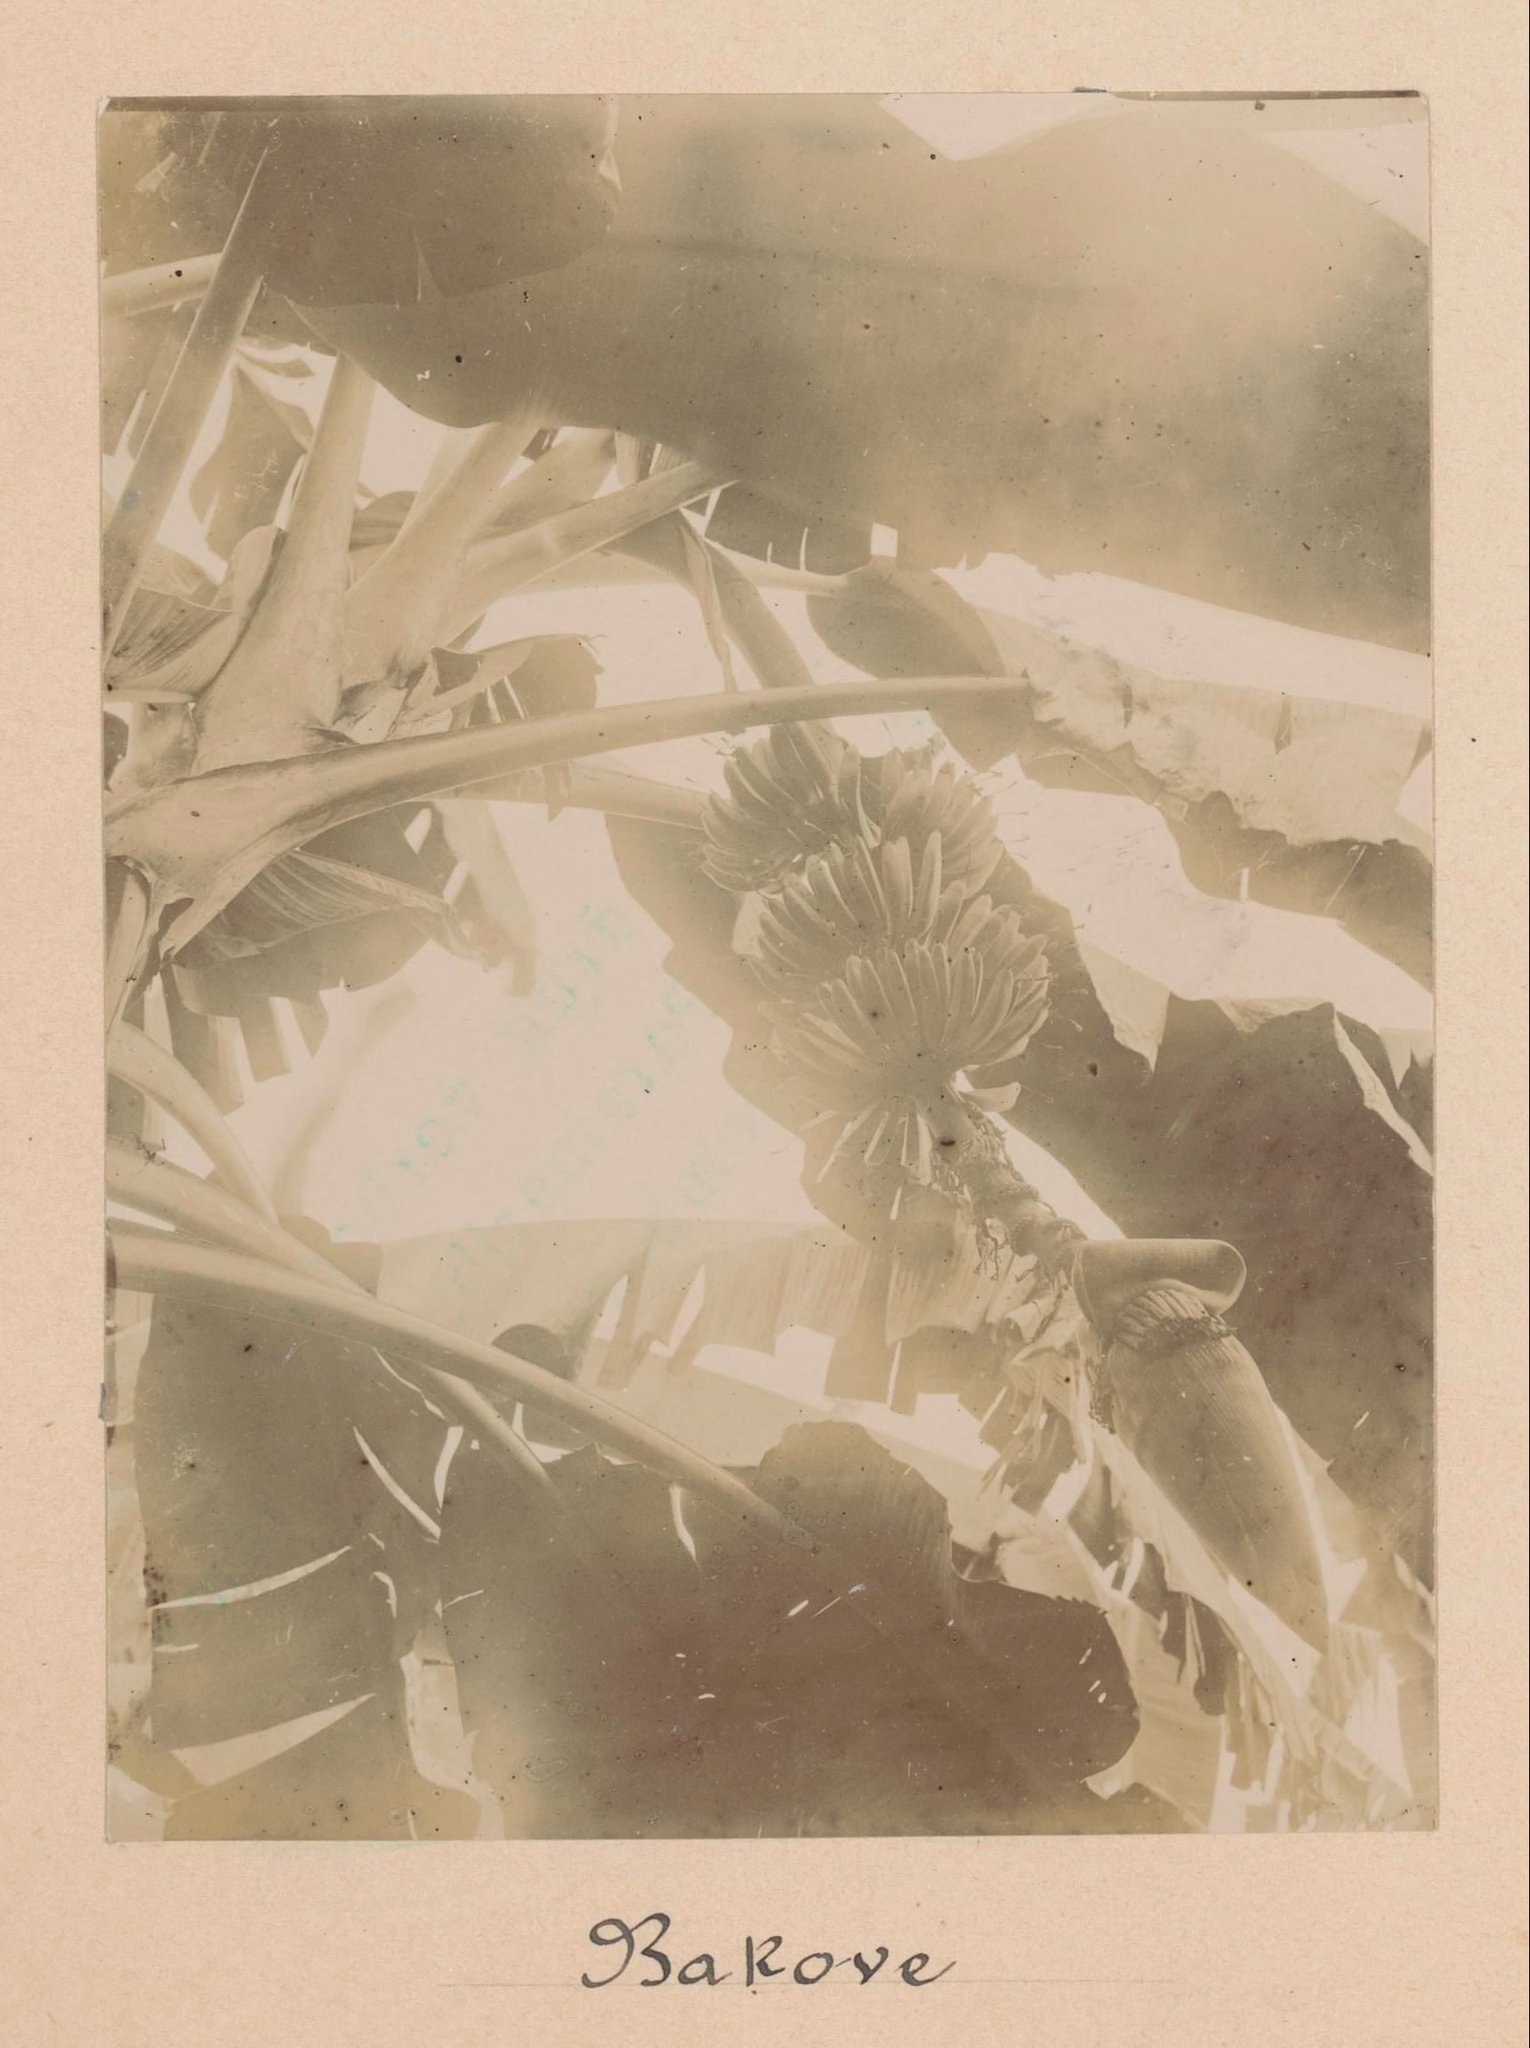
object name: photograph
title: Bakove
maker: eugen klein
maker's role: fotograaf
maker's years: 1869-1927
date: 1900-1905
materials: cardboard, photographic support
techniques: gelatin silver print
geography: suriname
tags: suriname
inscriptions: inscription: ‘Suriname / Bakove’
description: Een tros bananen in een bananenboom (bakove). Fotoafdruk op een blad geplakt samen met twee andere foto's. Onderdeel van een groep van 44 foto's van Paramaribo, Suriname en Curaçao, ca. 1900-1905, opgeplakt op kartons en voorzien van opschriften.